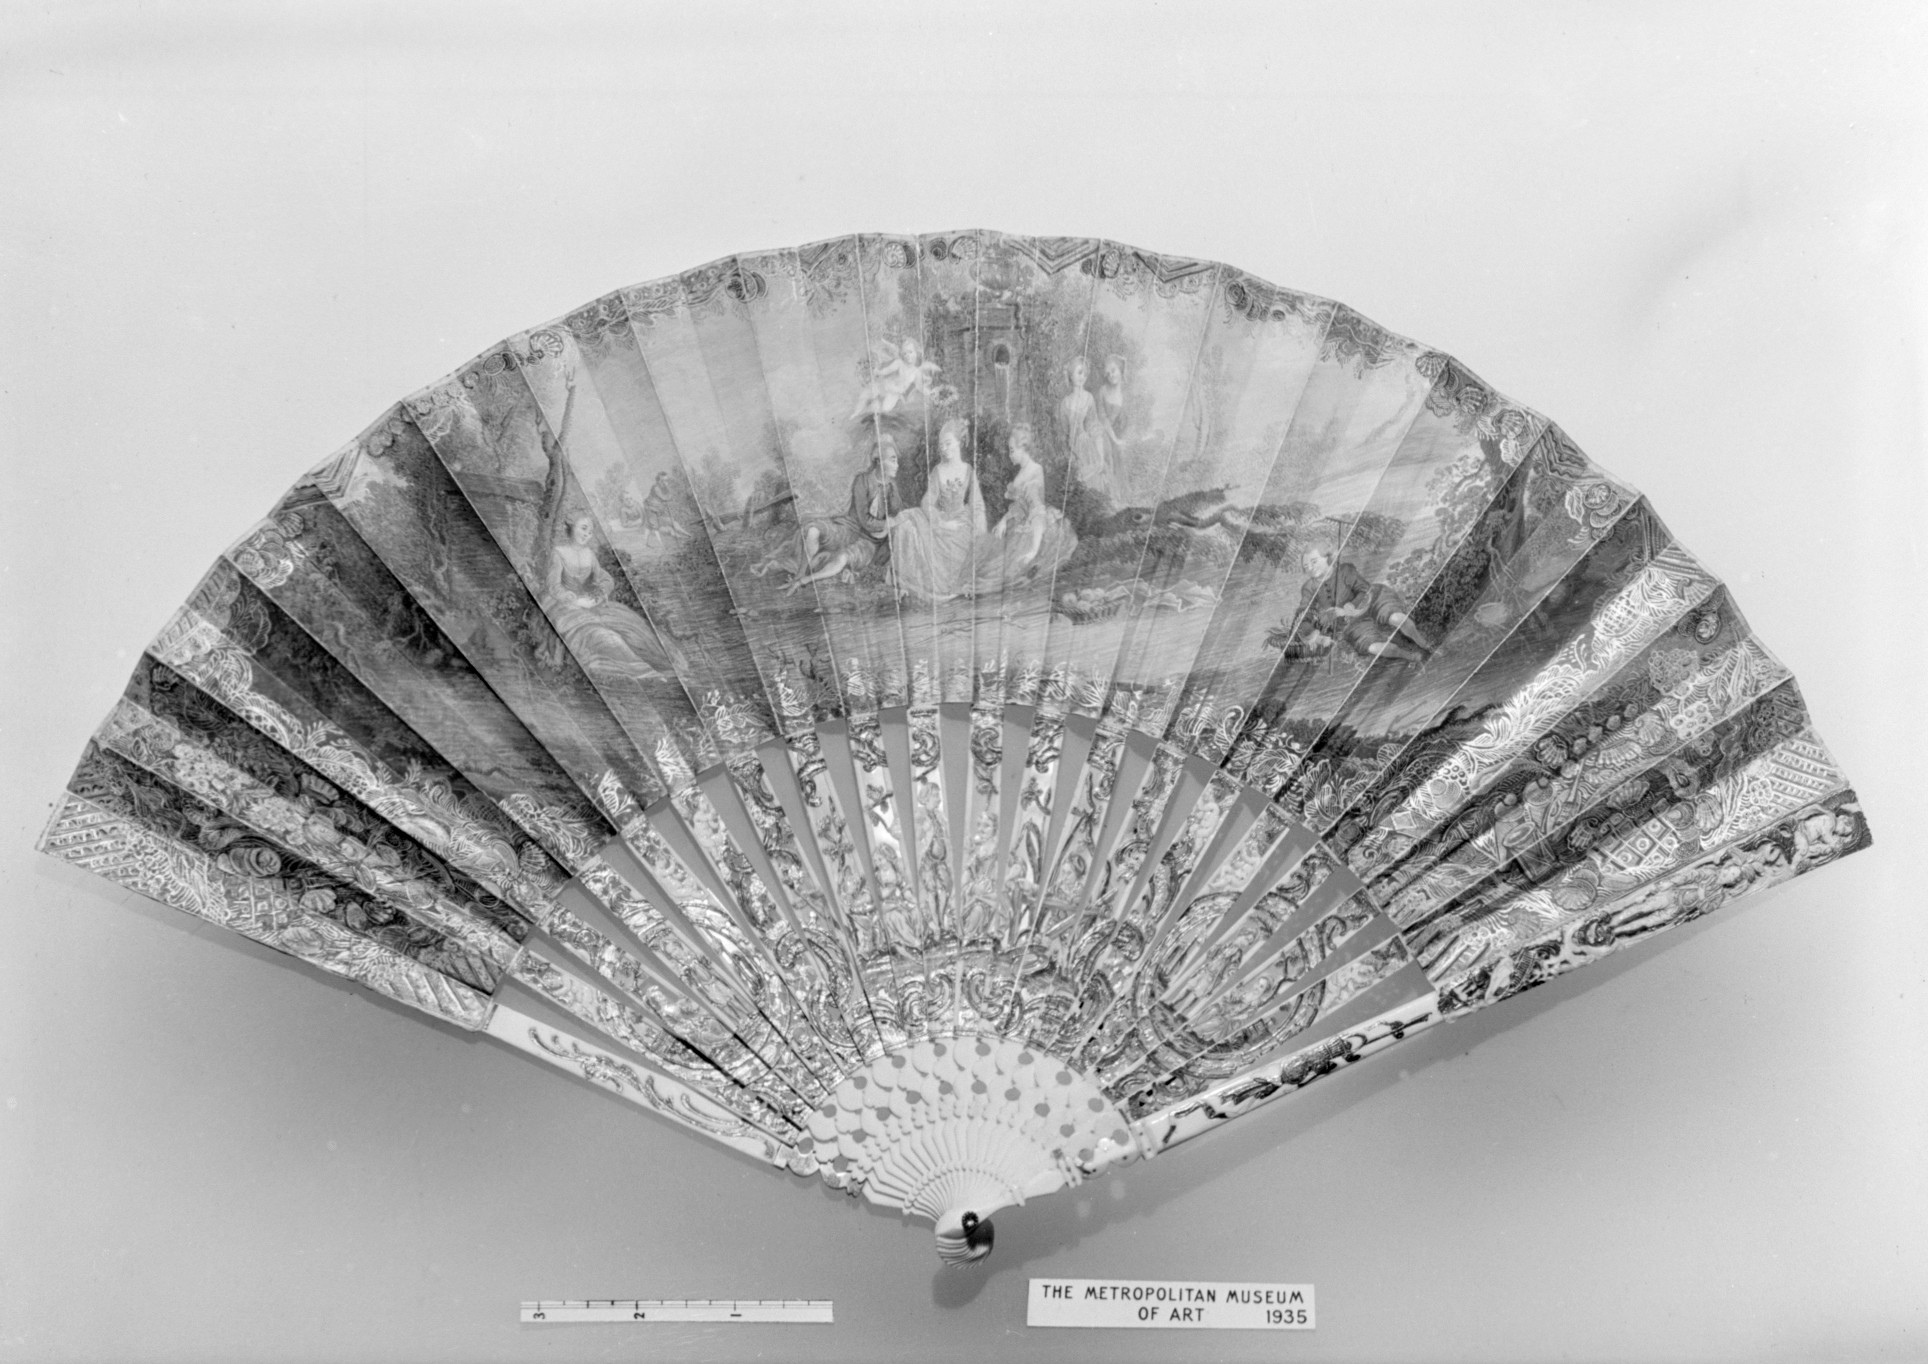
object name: fan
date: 1751-1775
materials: ivory, paper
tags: men,women